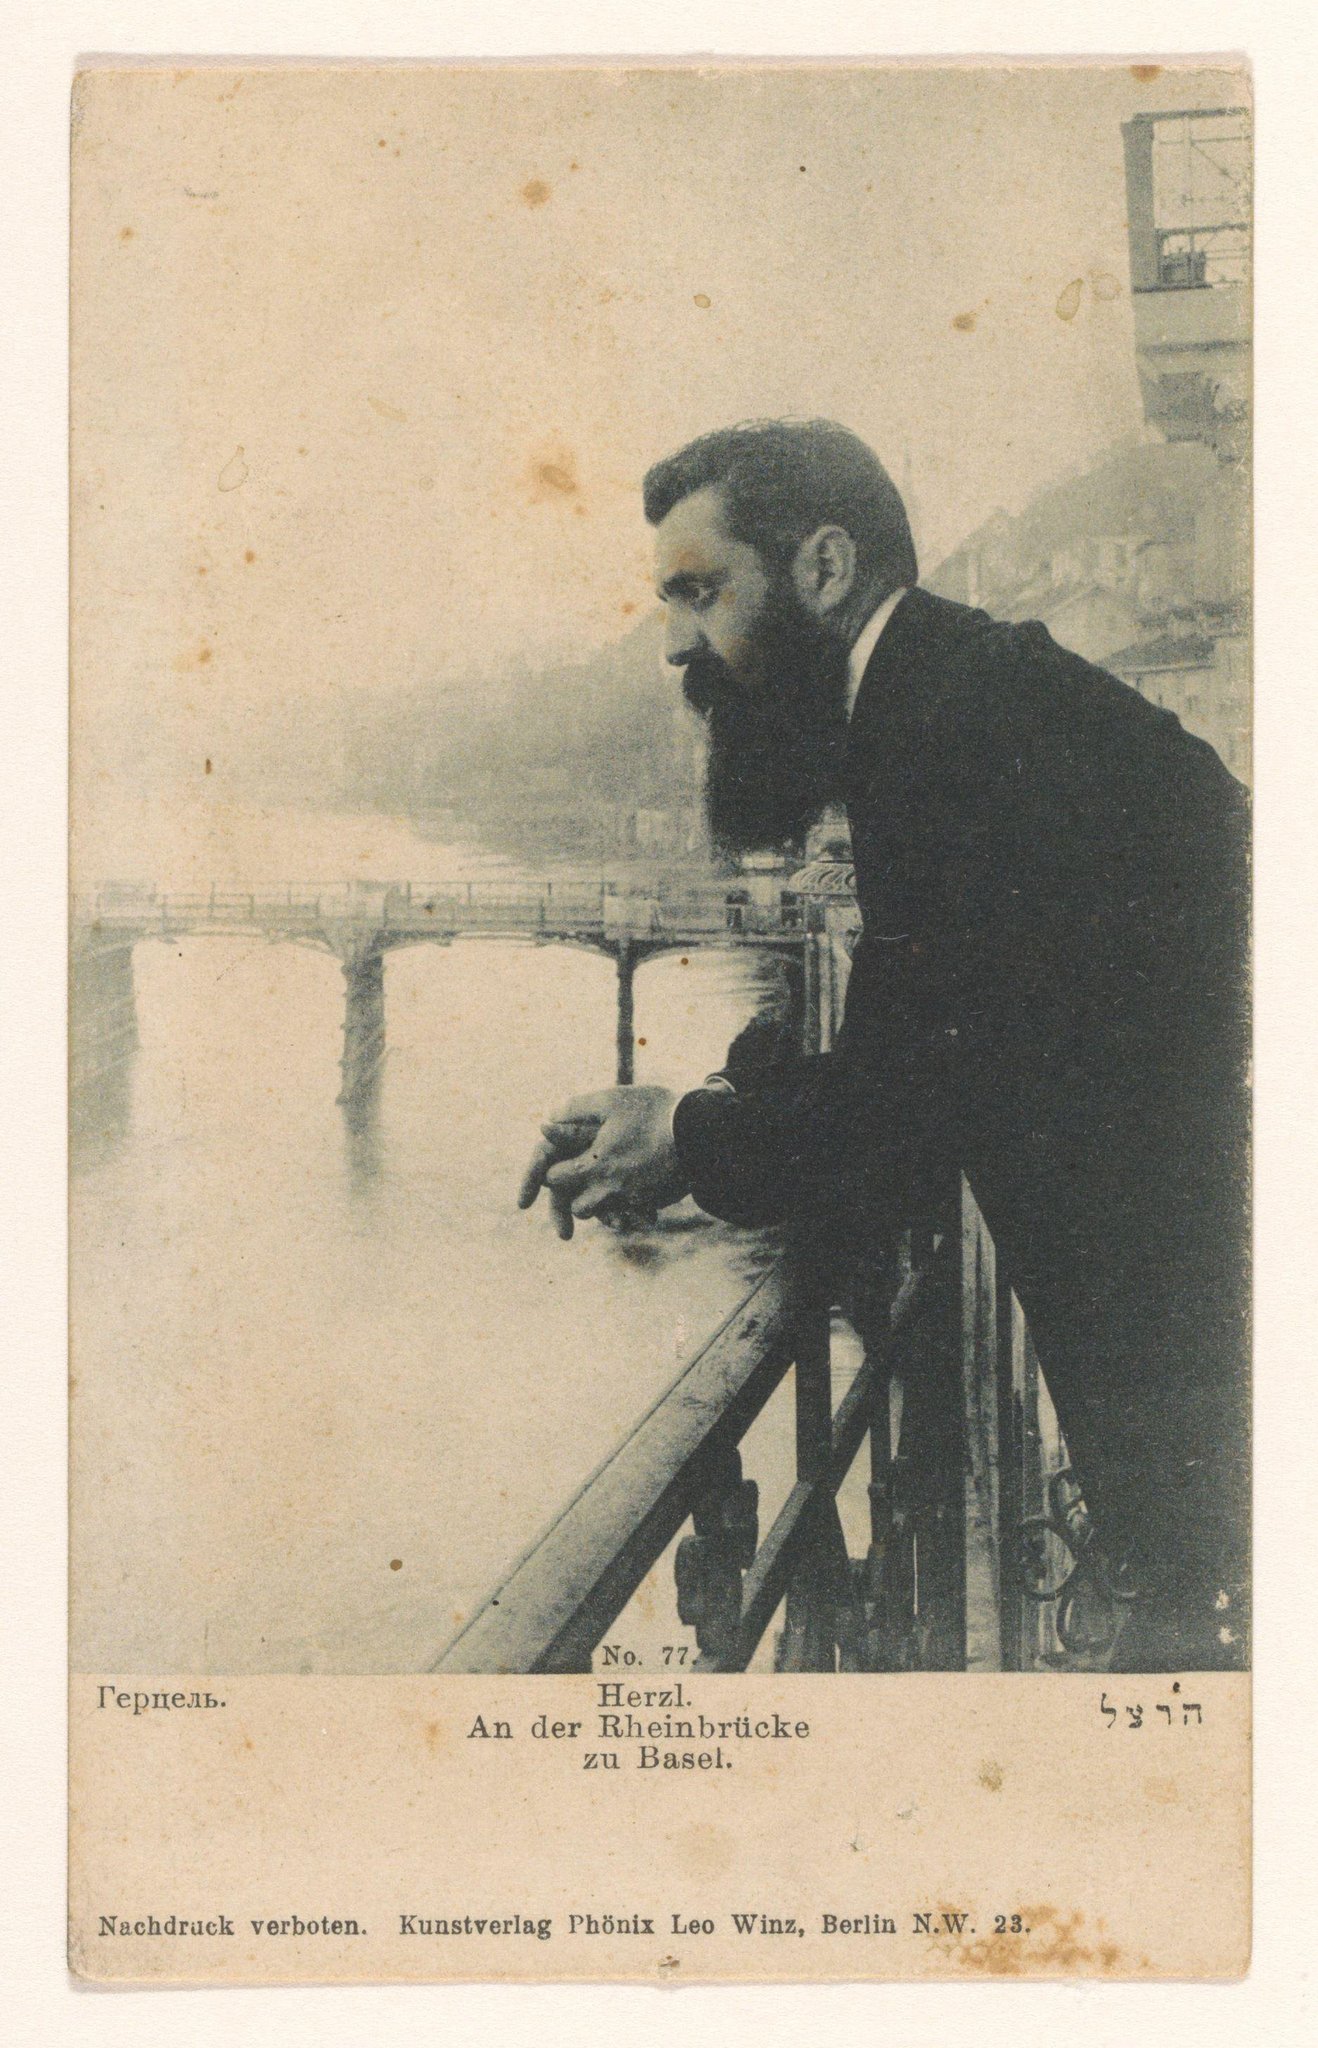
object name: ansichtkaart, prentbriefkaart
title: Portret van Theodor Herzl in Bazel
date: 1902-1904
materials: cardboard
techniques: photograph, letterpress printing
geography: basel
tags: leaning forward, river, historical persons, bridge, beard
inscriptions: inscription: ‘Post-Karte/ Levelezö-Lap/ (...) Unione postale universale.’, inscription: ‘No. 77./ Herzl./ An der Rheinbrücke/ zu Basel./ Nachdruck verboten. Kunstverlag Phönix Leo Winz, Berlin N.W. 23.’